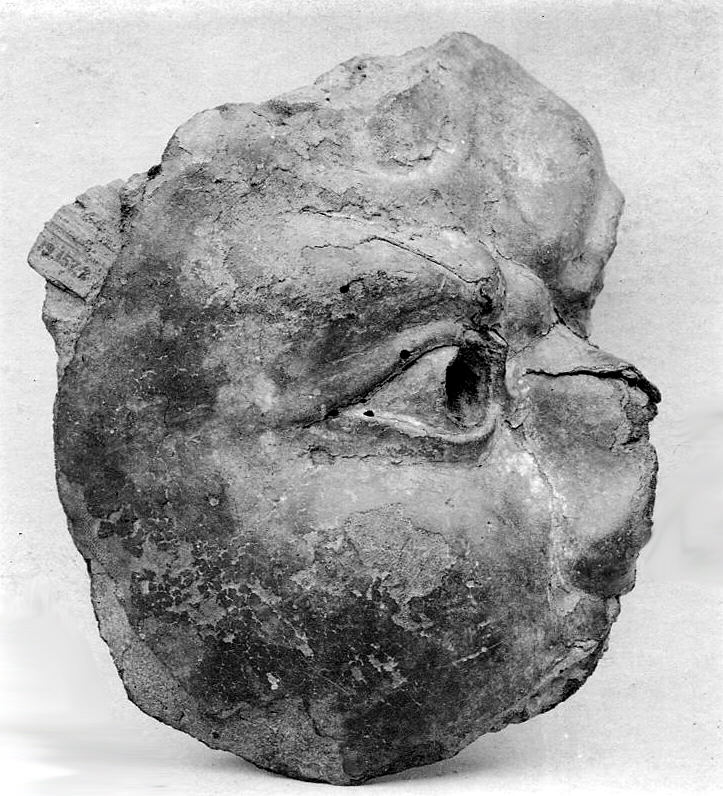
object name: fragment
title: Fragment: Head of Buddhist Image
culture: japanese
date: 701-800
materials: lacquer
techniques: painting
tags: buddhism